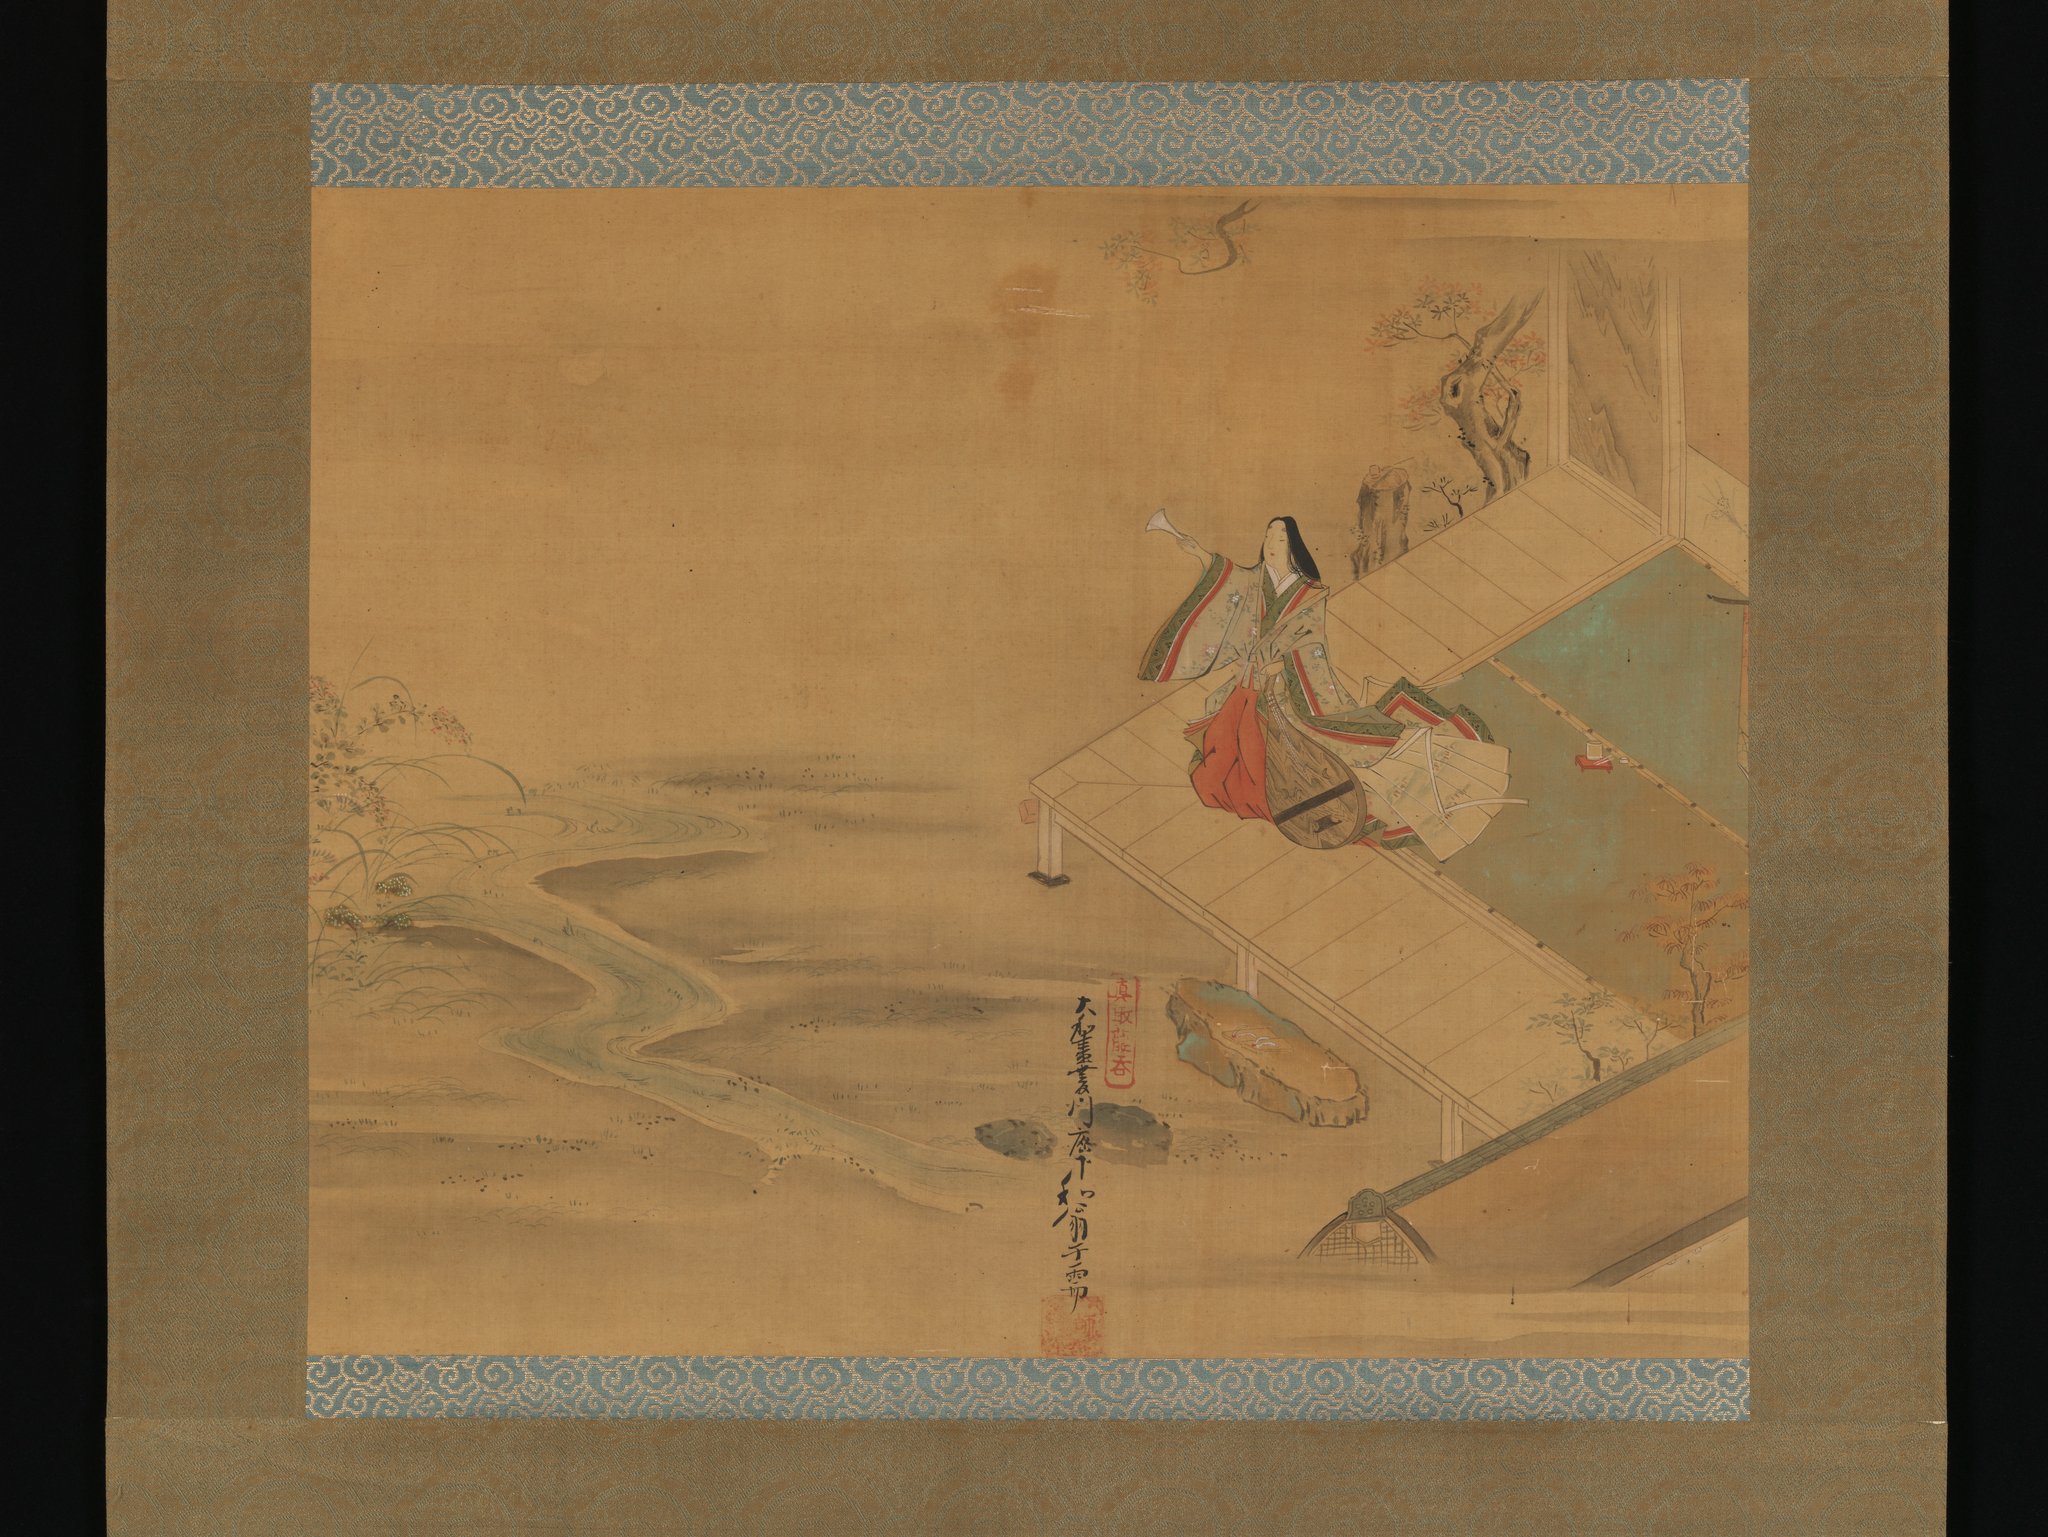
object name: hanging scroll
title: Princess Ogimi from the "Bridge Maiden" (Hashihime) chapter from The Tale of Genji (Genji Monogatari)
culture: japanese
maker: hishikawa waō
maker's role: artist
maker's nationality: japanese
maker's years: 1700-1733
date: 1701-1733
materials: gold, ink, silk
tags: bridges,princesses,women